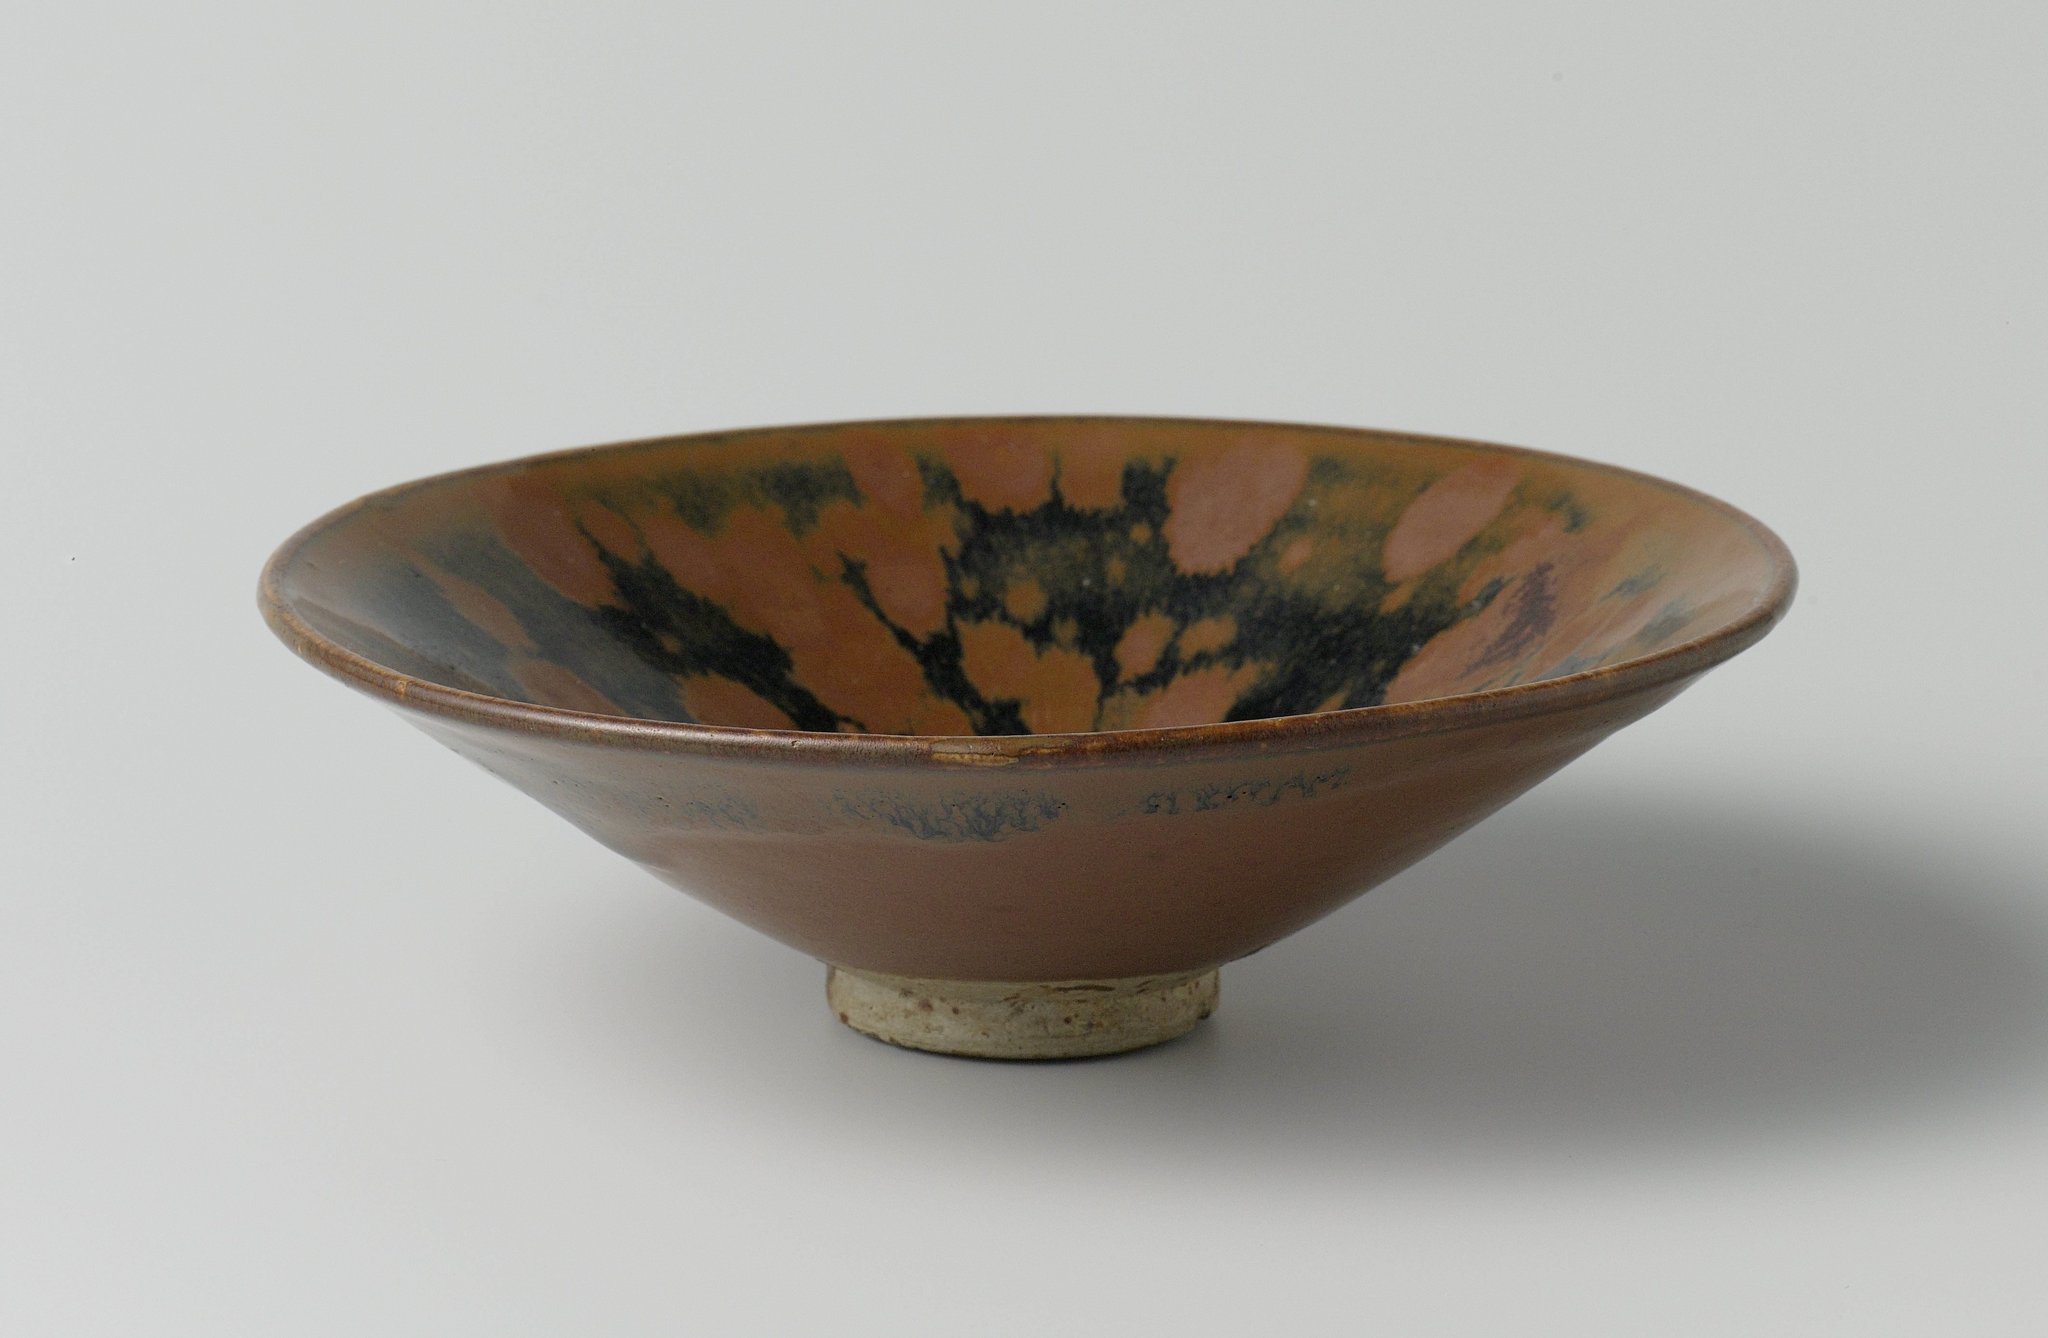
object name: tea bowl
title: Tea bowl with a 'patridge-feather' glaze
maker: Anonymous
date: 1000-1300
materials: glaze, stoneware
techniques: firing, turning, vitrification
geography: china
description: Theekom van steengoed met een rechte, spreidende wand, gedeeltelijk bedekt met een roodbruin glazuur met donkere vlekken (patridge-feather). Het onderste deel van de kom is ongeglazuurd. Henan (Cizhou).